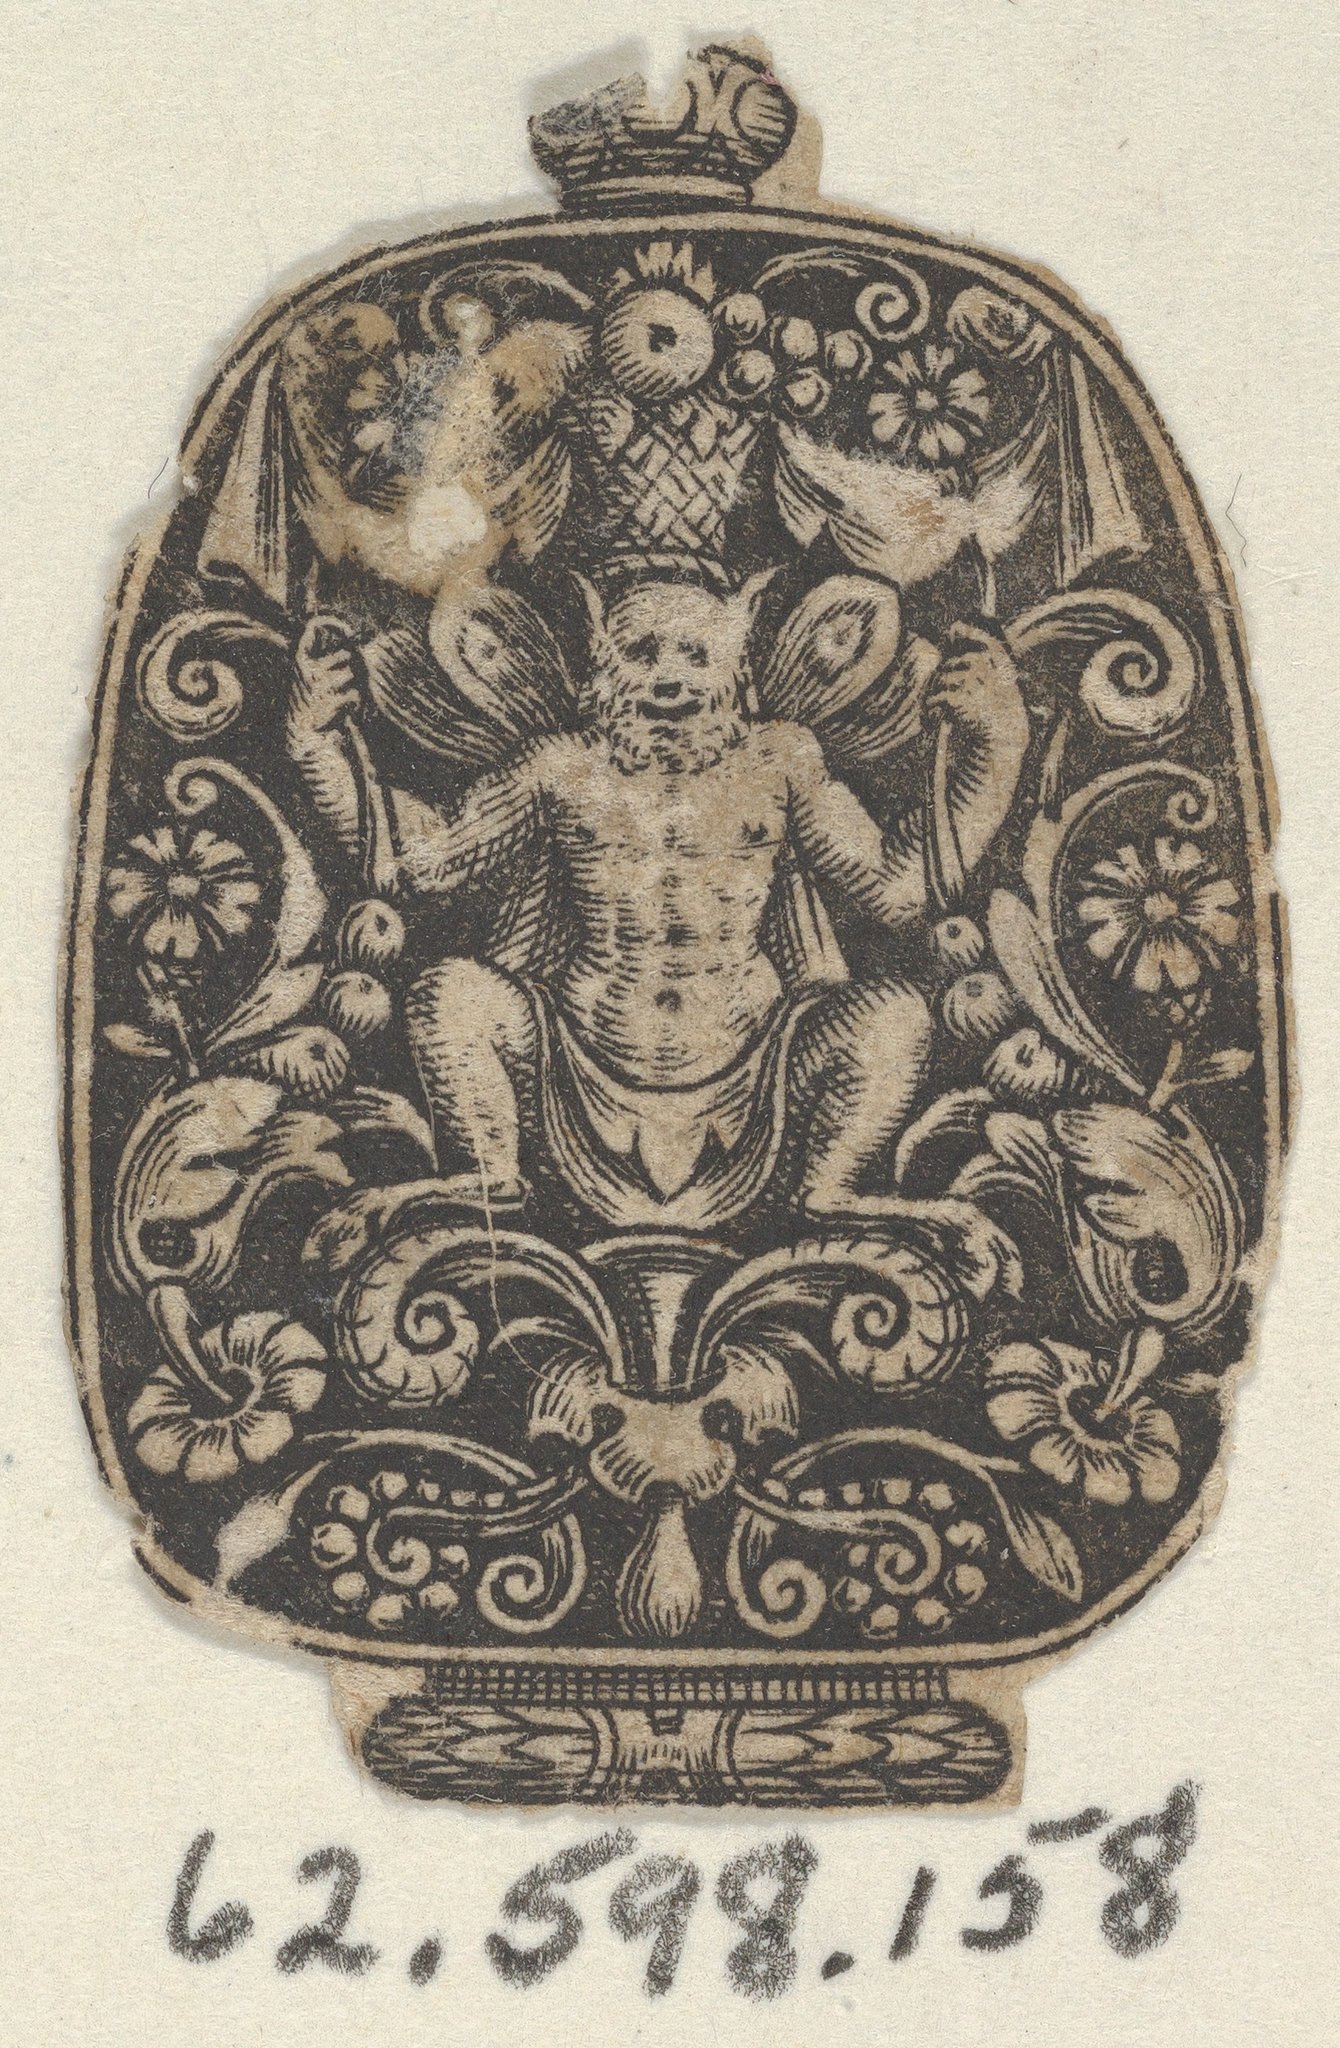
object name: print ornament architecture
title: Design for a Sword Pommel with a Crouching Satyr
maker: theodor de bry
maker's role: artist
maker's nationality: netherlandish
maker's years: 1528-1598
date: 1592-1593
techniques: embroidery, engraving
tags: satyrs,flowers